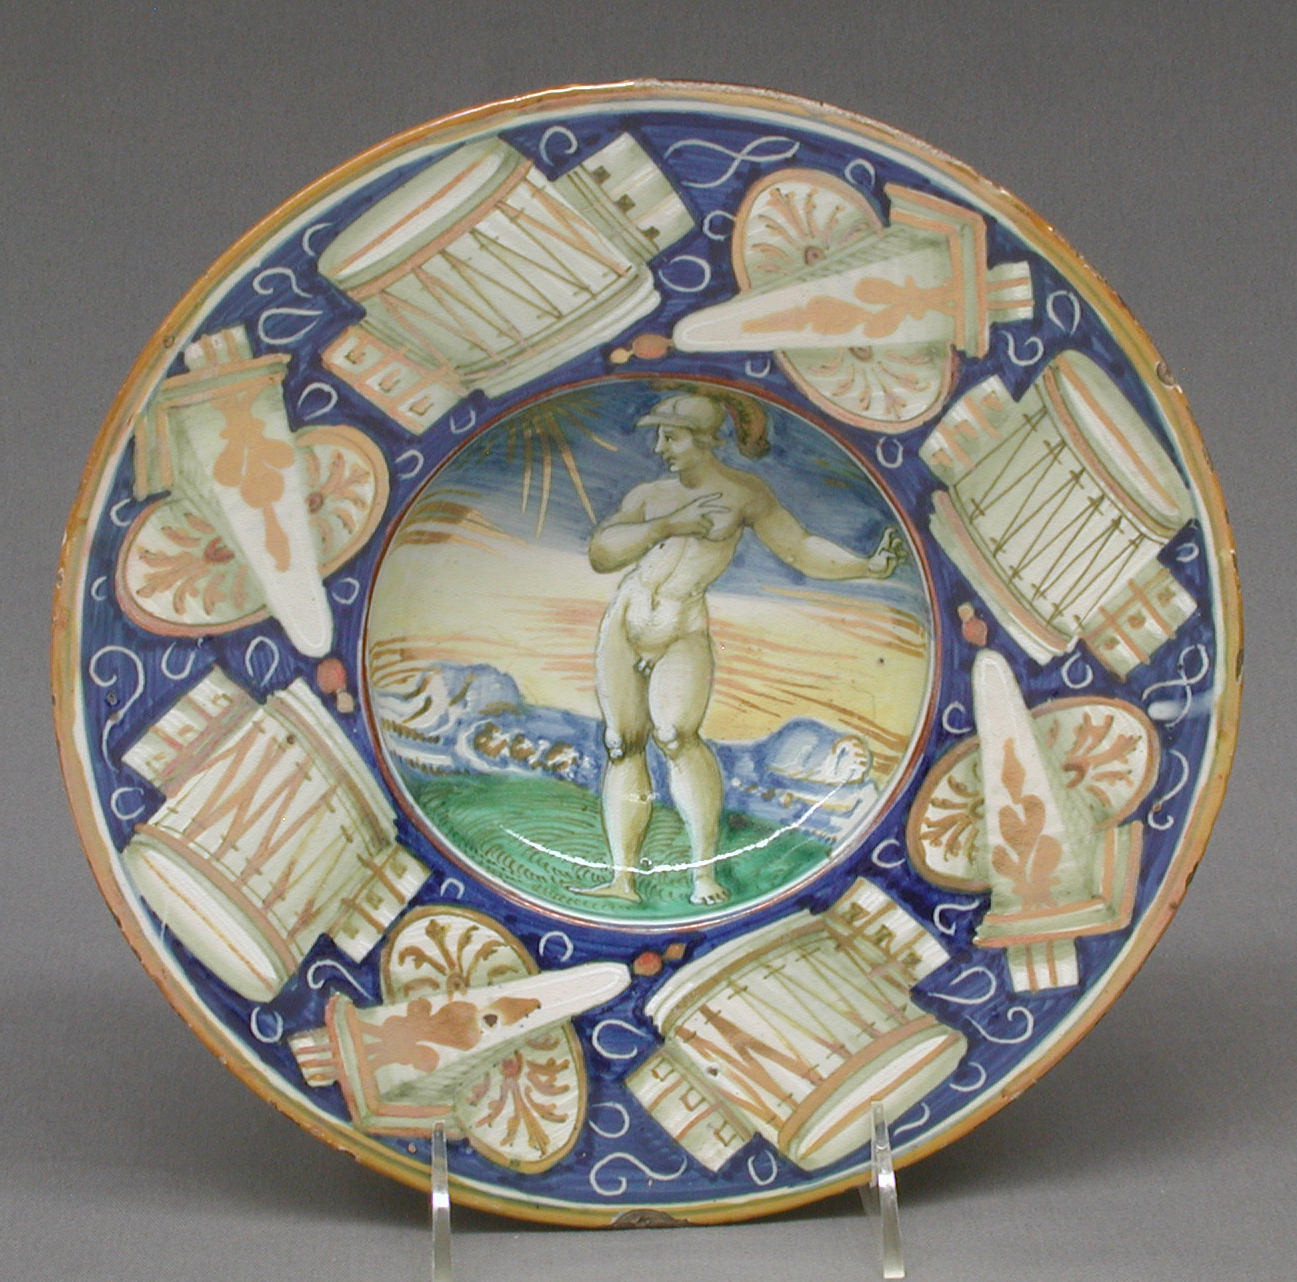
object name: plate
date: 1535-1540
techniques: maiolica, glazing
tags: male nudes